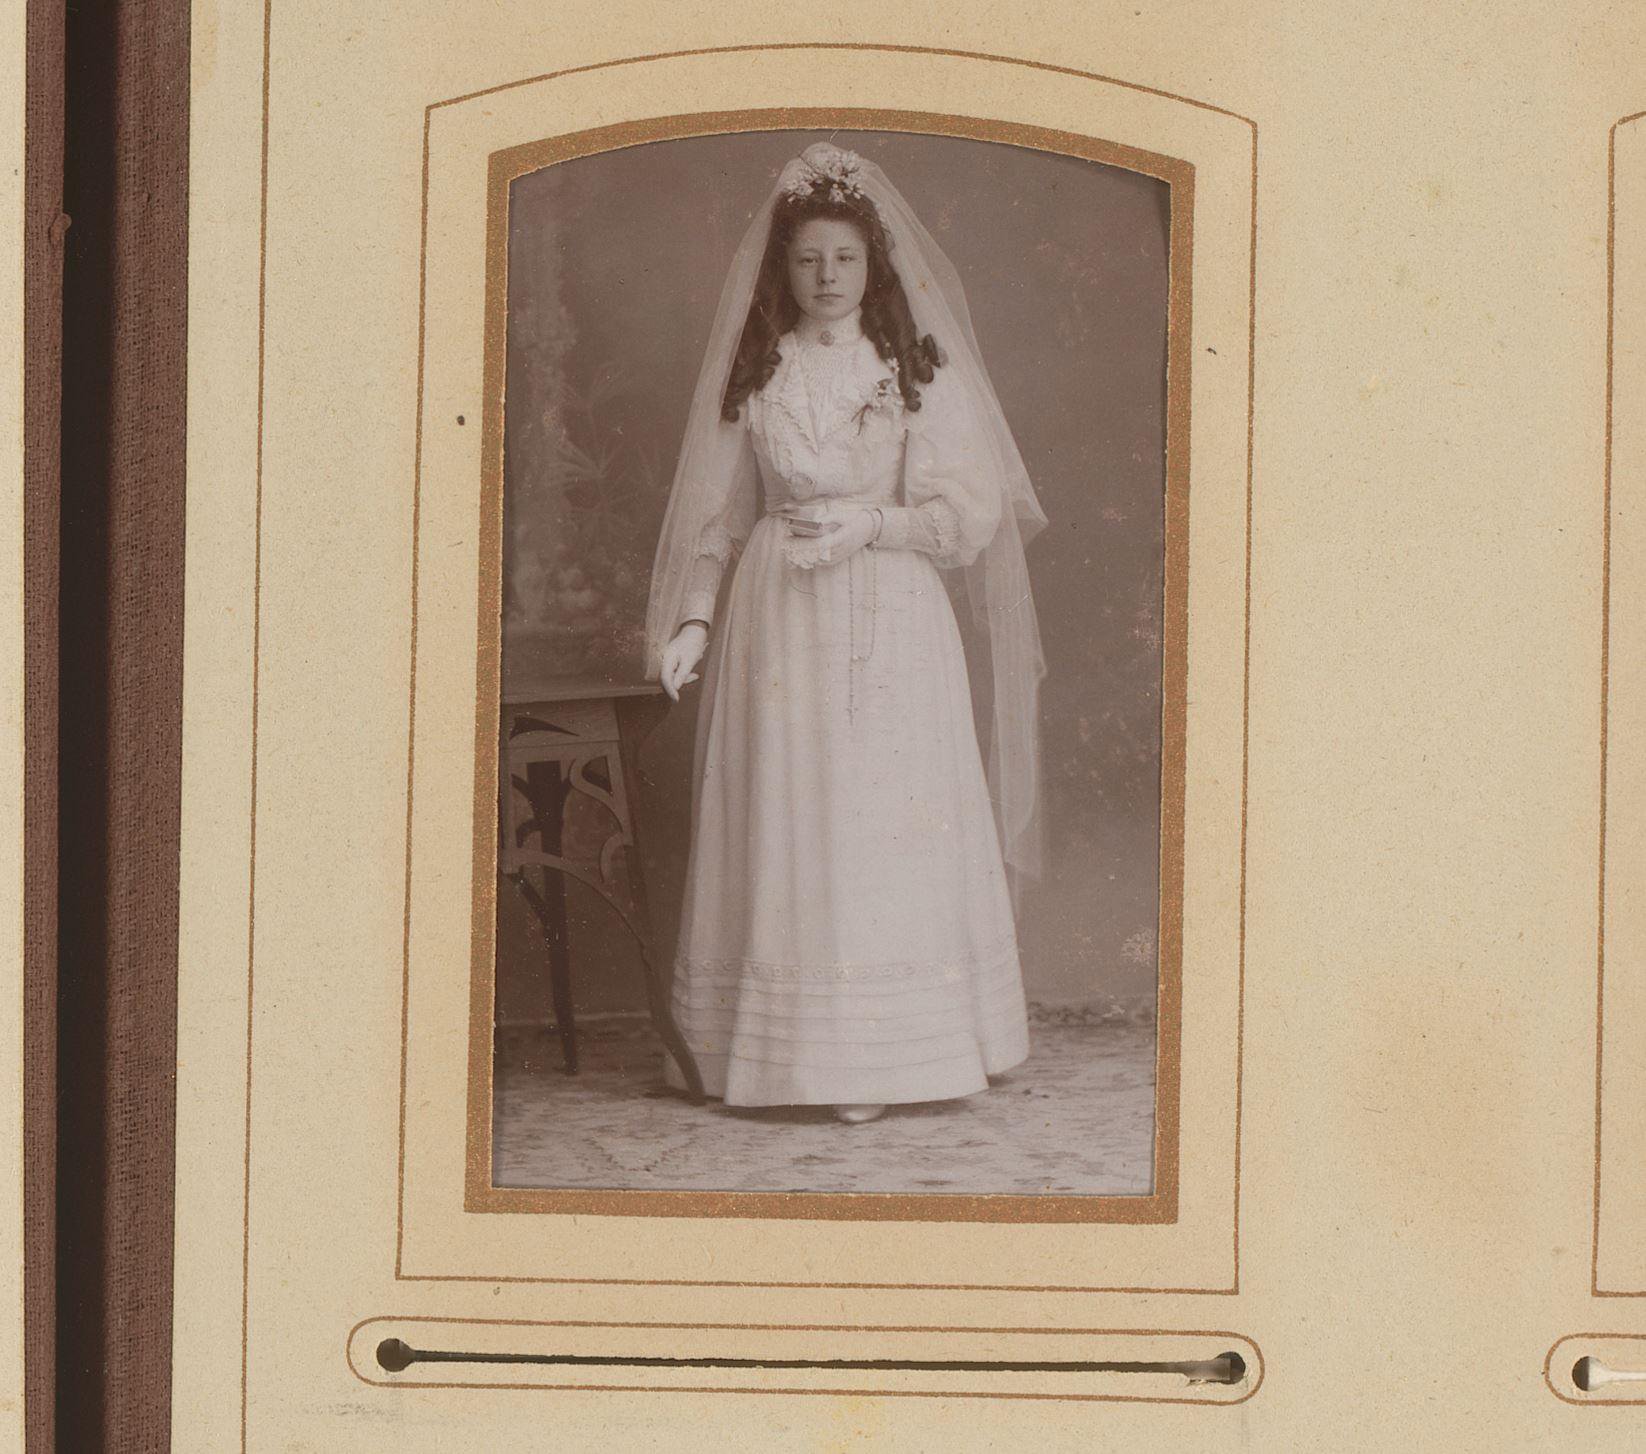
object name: photograph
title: Portret van een meisje in een communiejurk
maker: berend zweers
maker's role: fotograaf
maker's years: 1872-1946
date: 1923-1934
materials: cardboard, photographic support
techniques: collodion silver print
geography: haarlem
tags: communion dress, girl (child between toddler and youth)